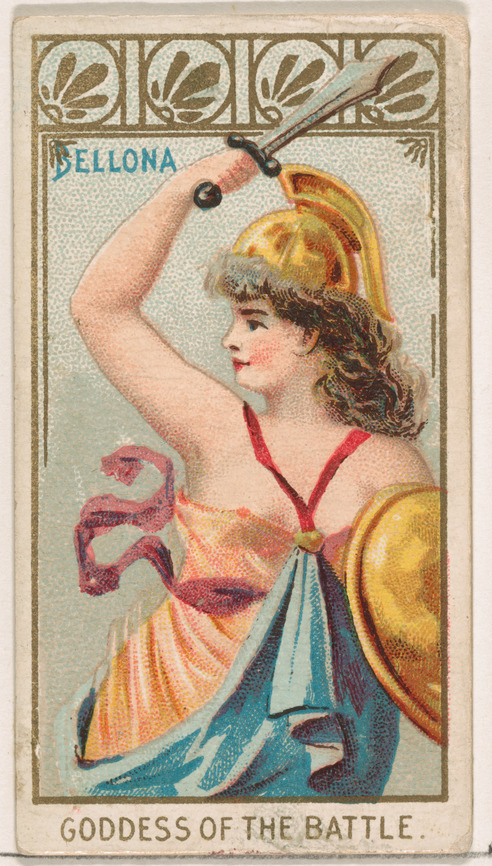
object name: print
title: Bellona, Goddess of the Battle, from the Goddesses of the Greeks and Romans series (N188) issued by Wm. S. Kimball & Co.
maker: william s. kimball & company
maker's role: publisher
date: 1889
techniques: color lithograph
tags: helmets,shields,daggers,goddess